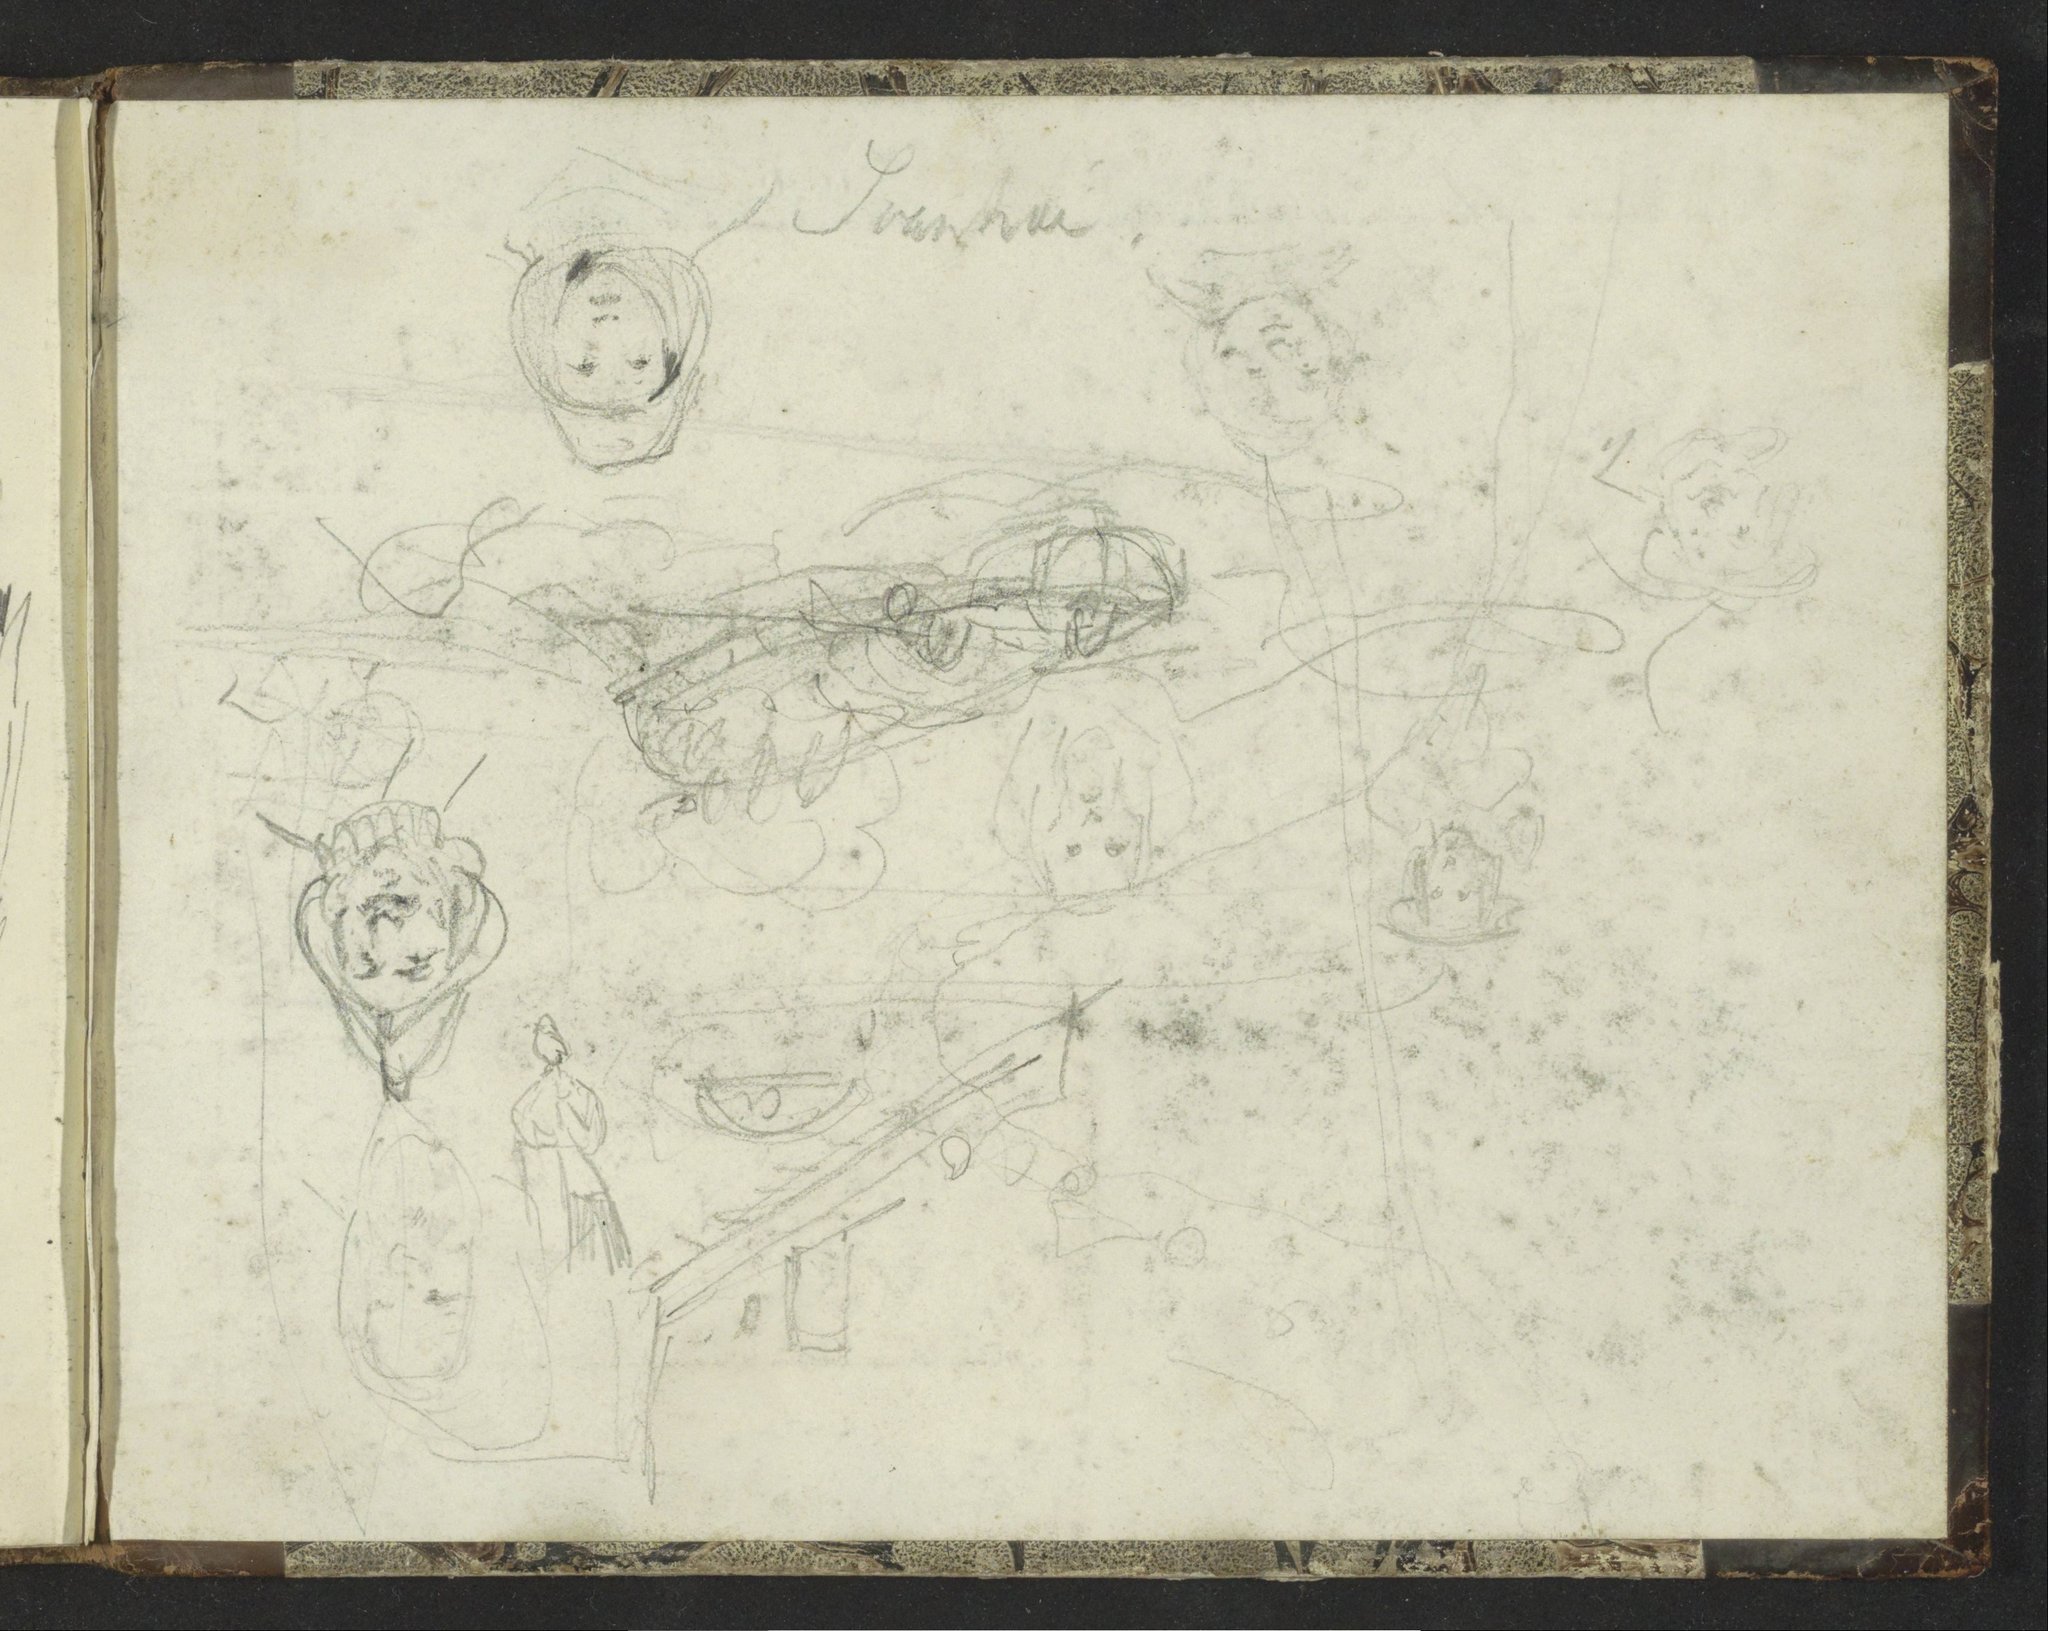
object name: sketchbook leaf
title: Studieblad met koppen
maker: willem hendrik schmidt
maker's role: draughtsman, painter, print maker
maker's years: 1809-1849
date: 1819-1849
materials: paper, pencil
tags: head (human), head-gear (+ men's clothes)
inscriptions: annotation: ‘Joanna.’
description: Onder andere monniken en een man met een helm. Achterste schutblad uit een schetsboek met 58 bladen.